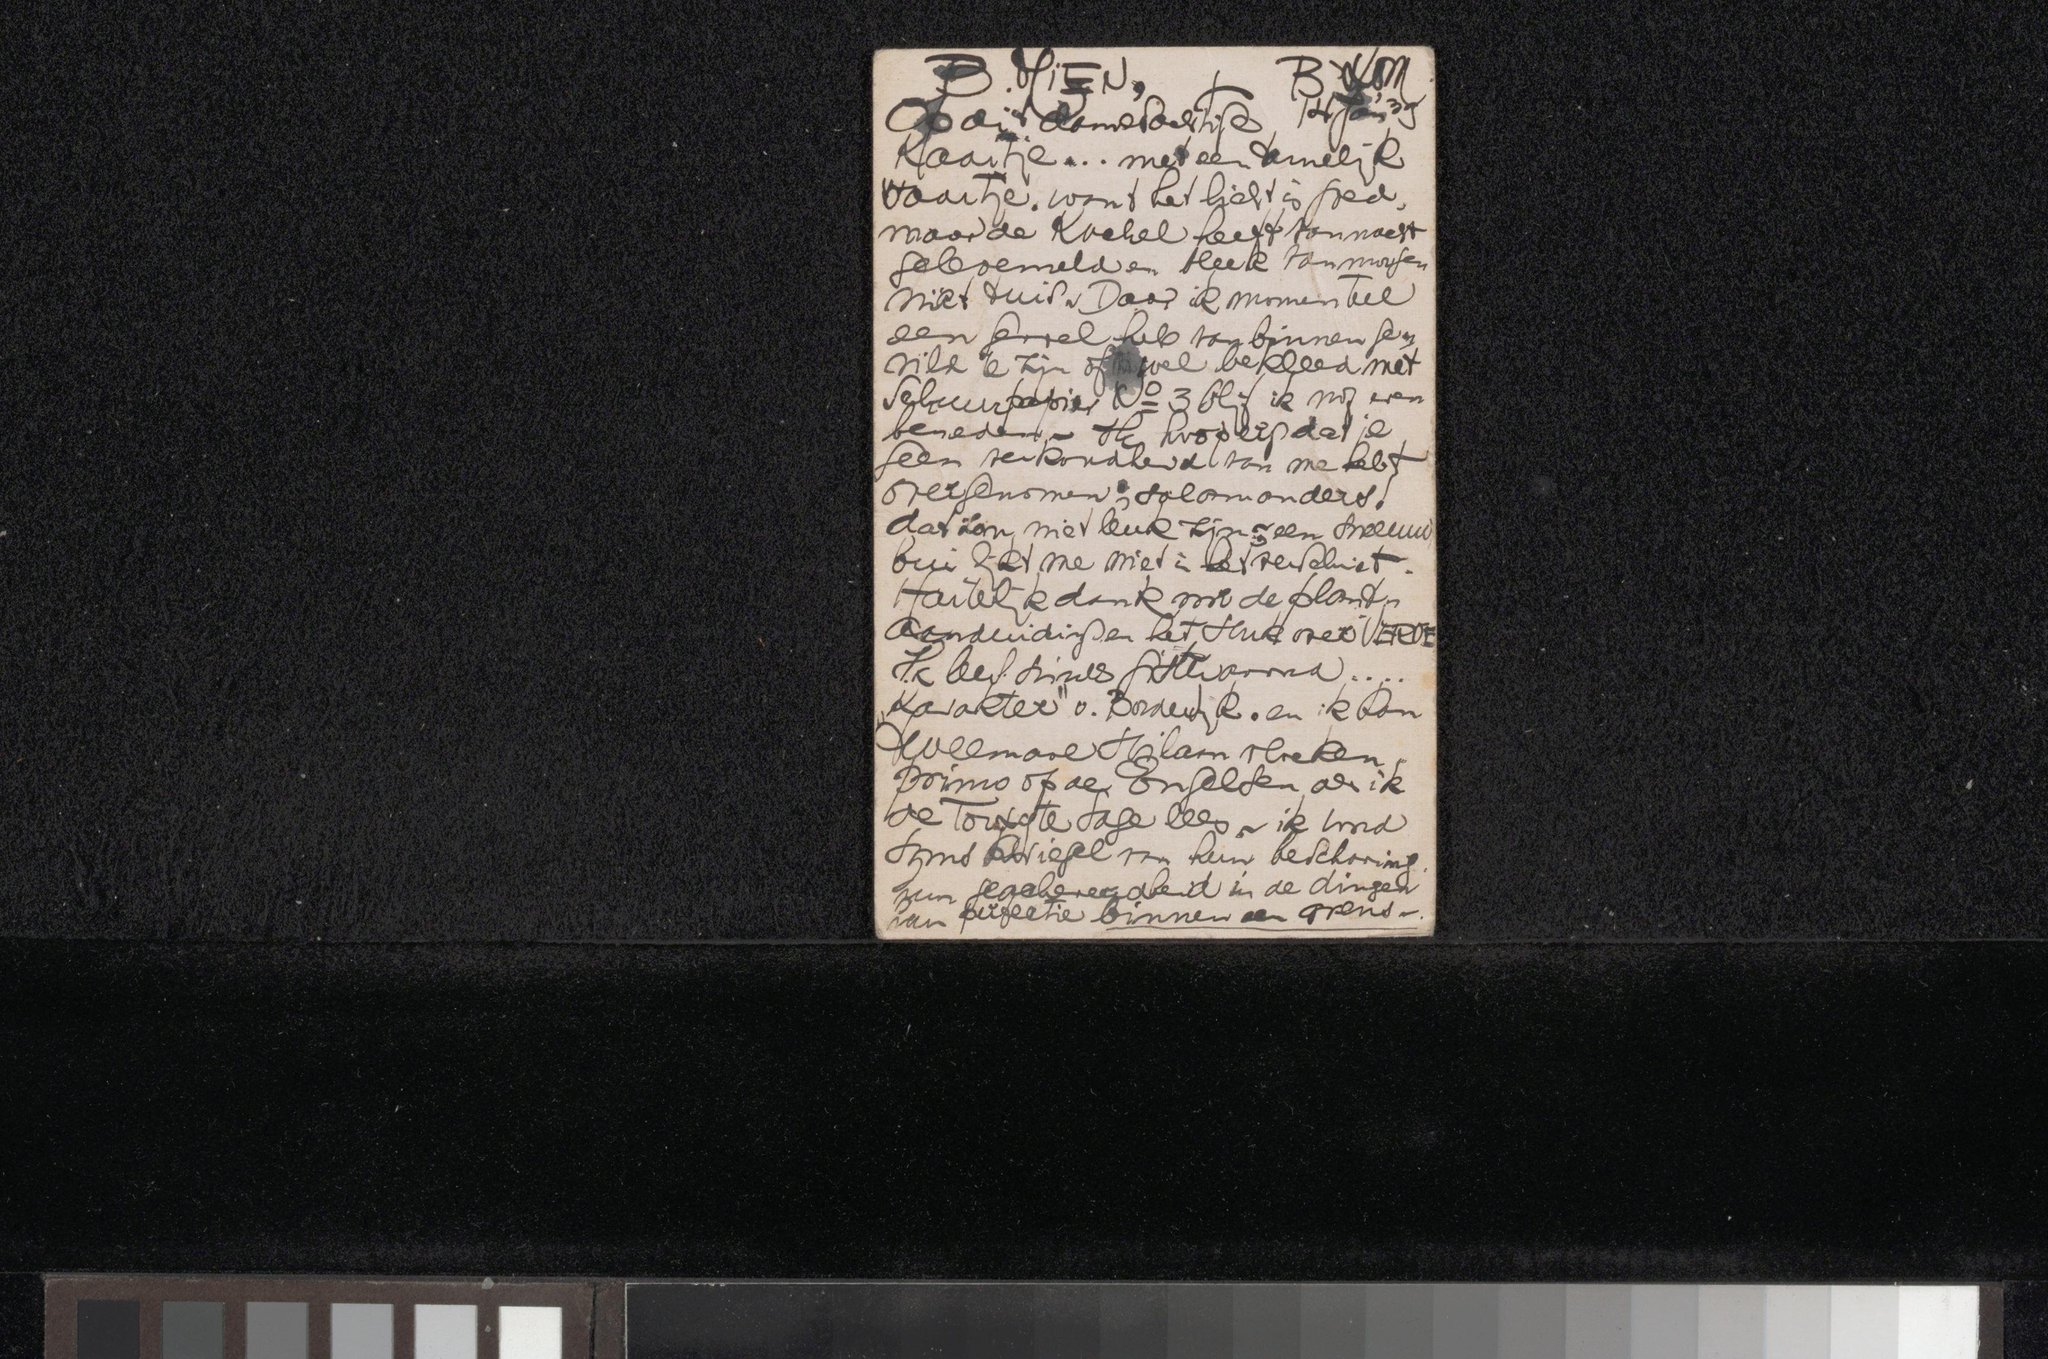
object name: letter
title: Brief aan Mien Cambier van Nooten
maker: dick ket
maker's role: draughtsman, print maker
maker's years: 1902-1940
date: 1939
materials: cardboard, ink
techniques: pen, writing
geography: bennekom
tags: amsterdam, the hague, arnhem, mien cambier van nooten, literature ~ arts, portrait, self-portrait of artist, diseases